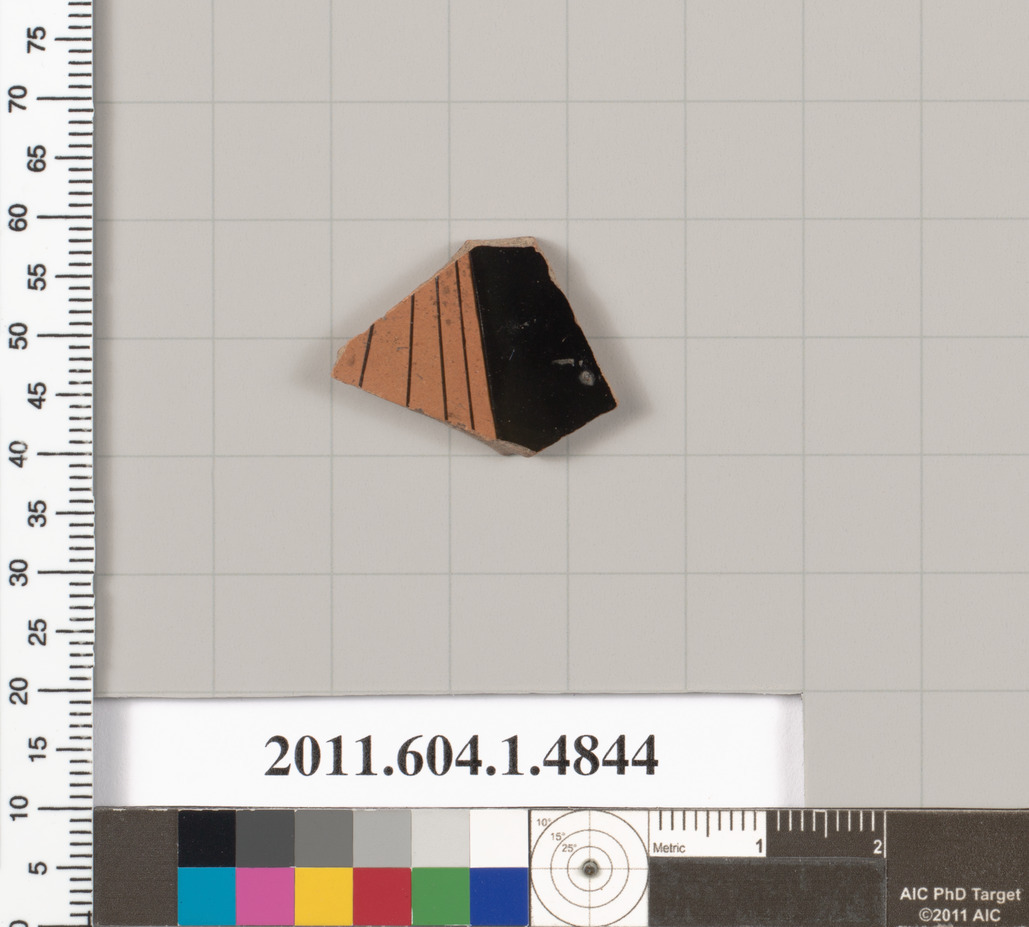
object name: kylix fragment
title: Terracotta fragment of a kylix (drinking cup)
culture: greek, attic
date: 475-451 BCE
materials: terracotta